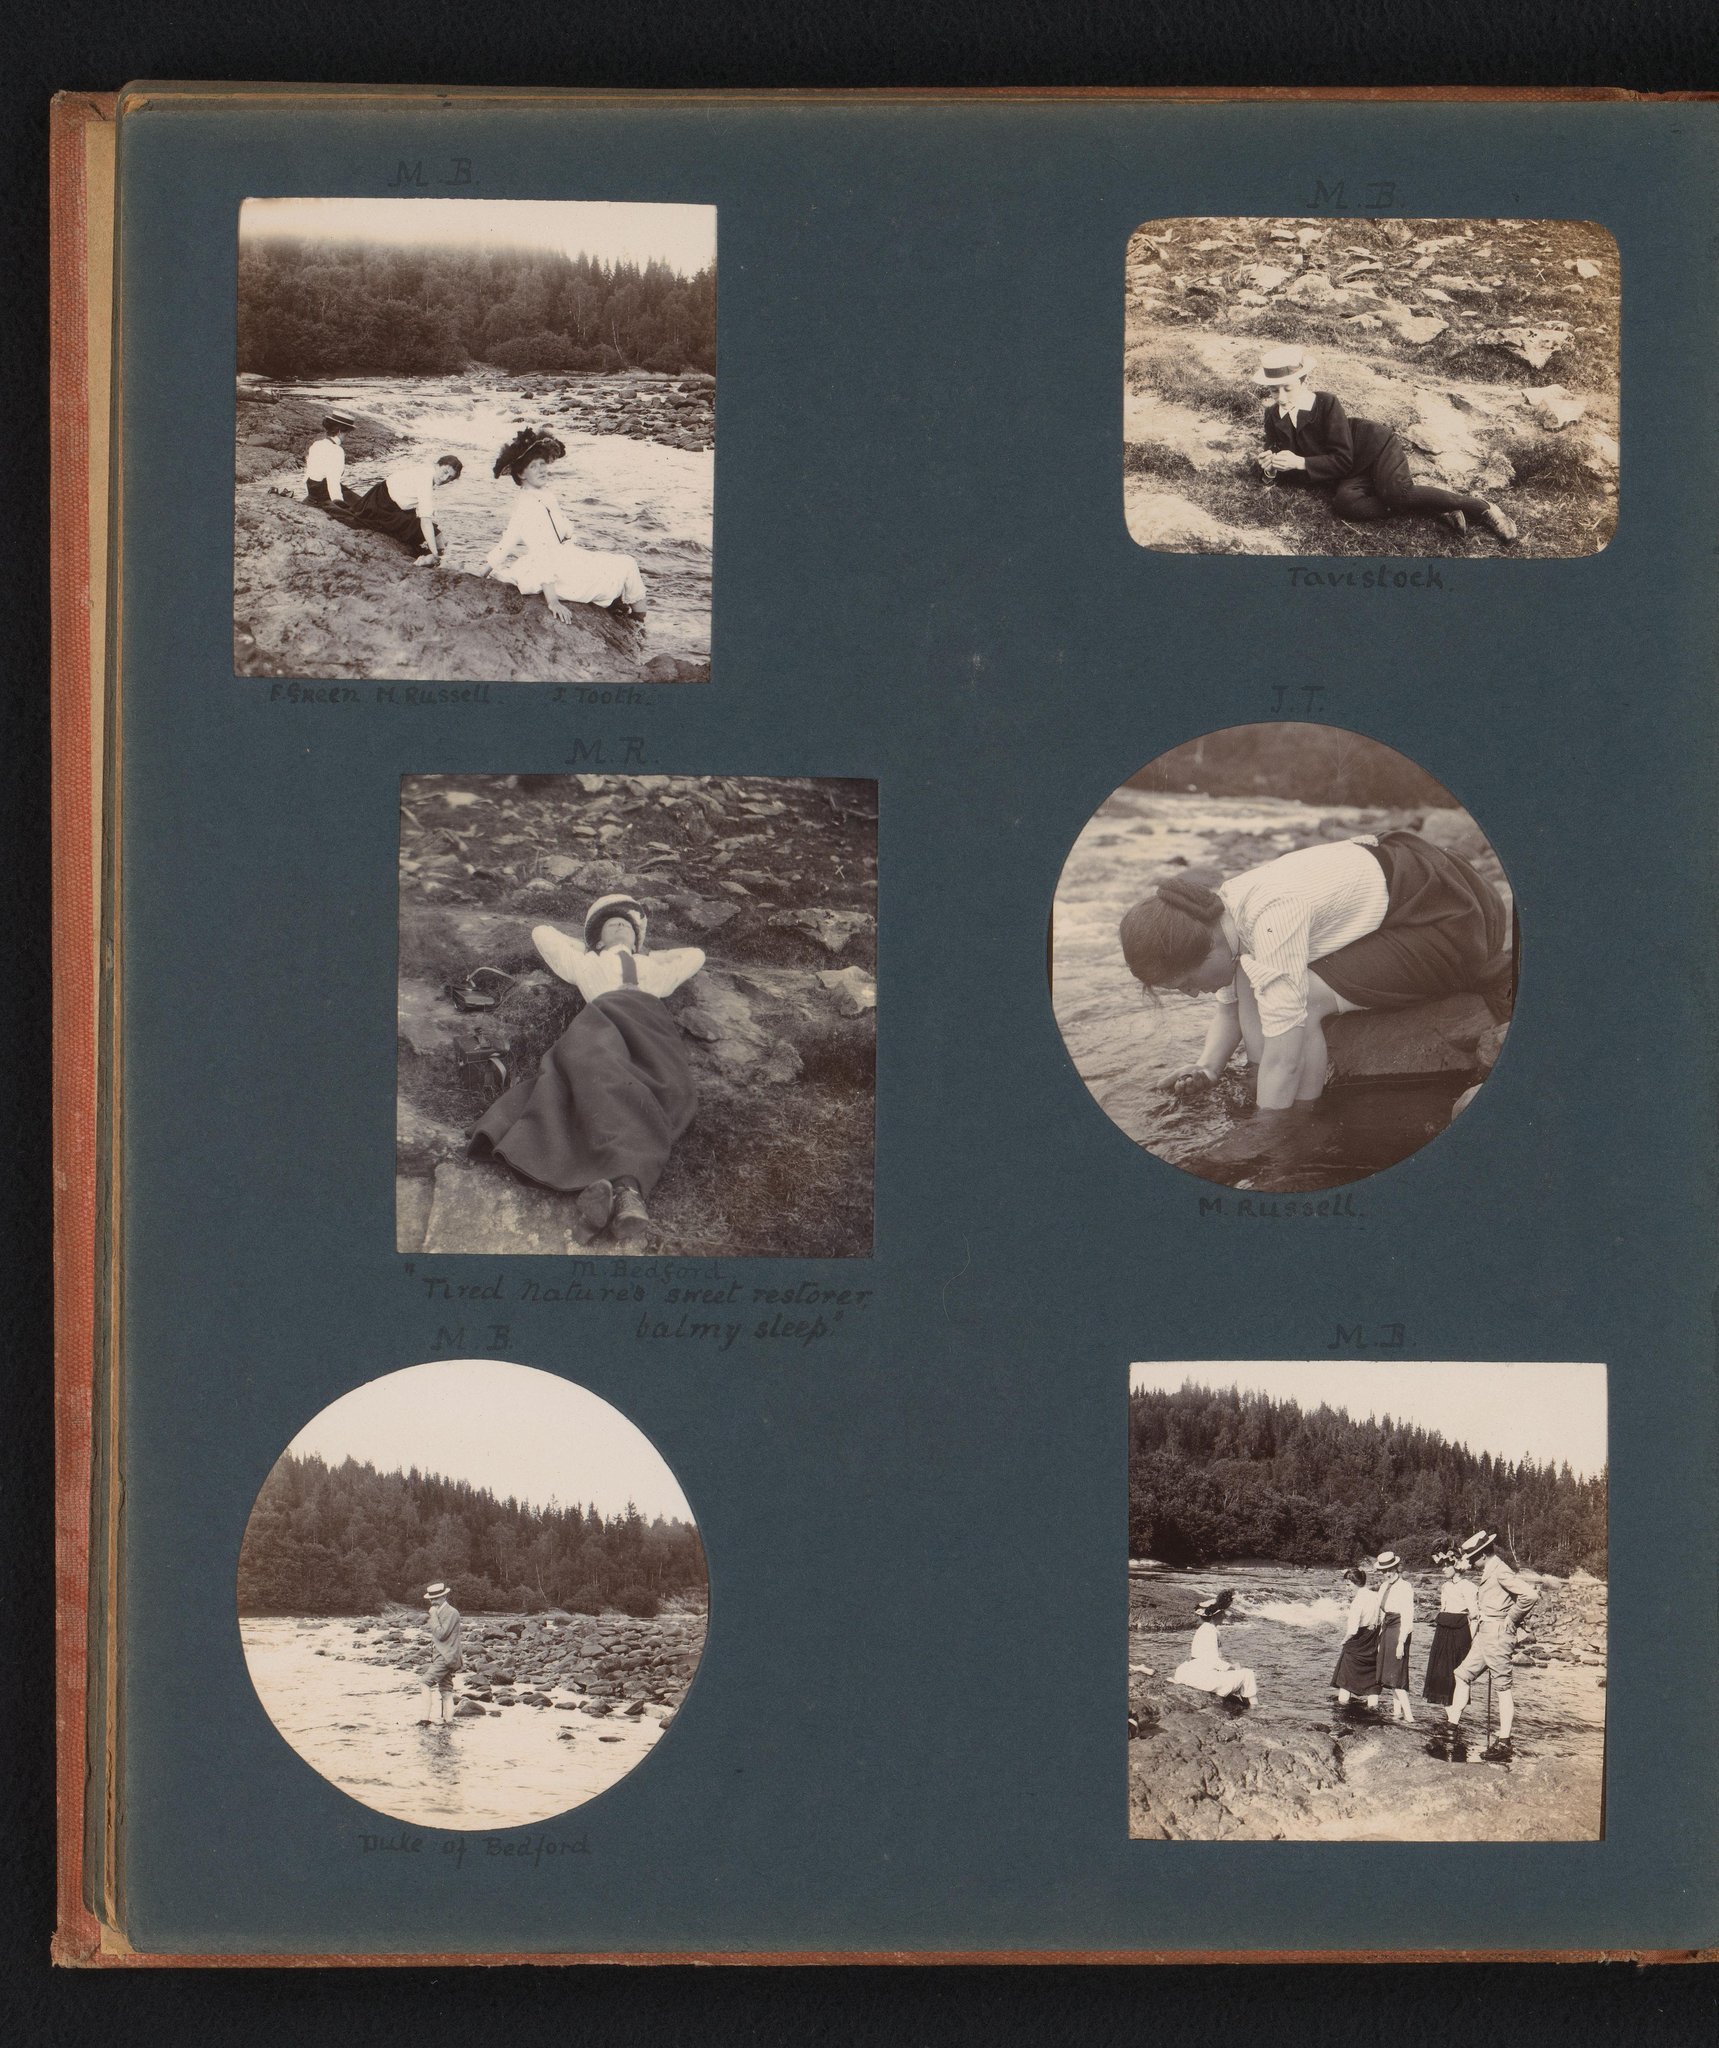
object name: photograph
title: Zes foto's van het reisgezelschap bij een beek, Noorwegen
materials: paper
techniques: gelatin silver print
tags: j. tooth, f. green (fotograaf), duchess of bedford, london, mary russell, politician, enjoying nature, brook, norway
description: Deze foto's maken deel uit van een album.